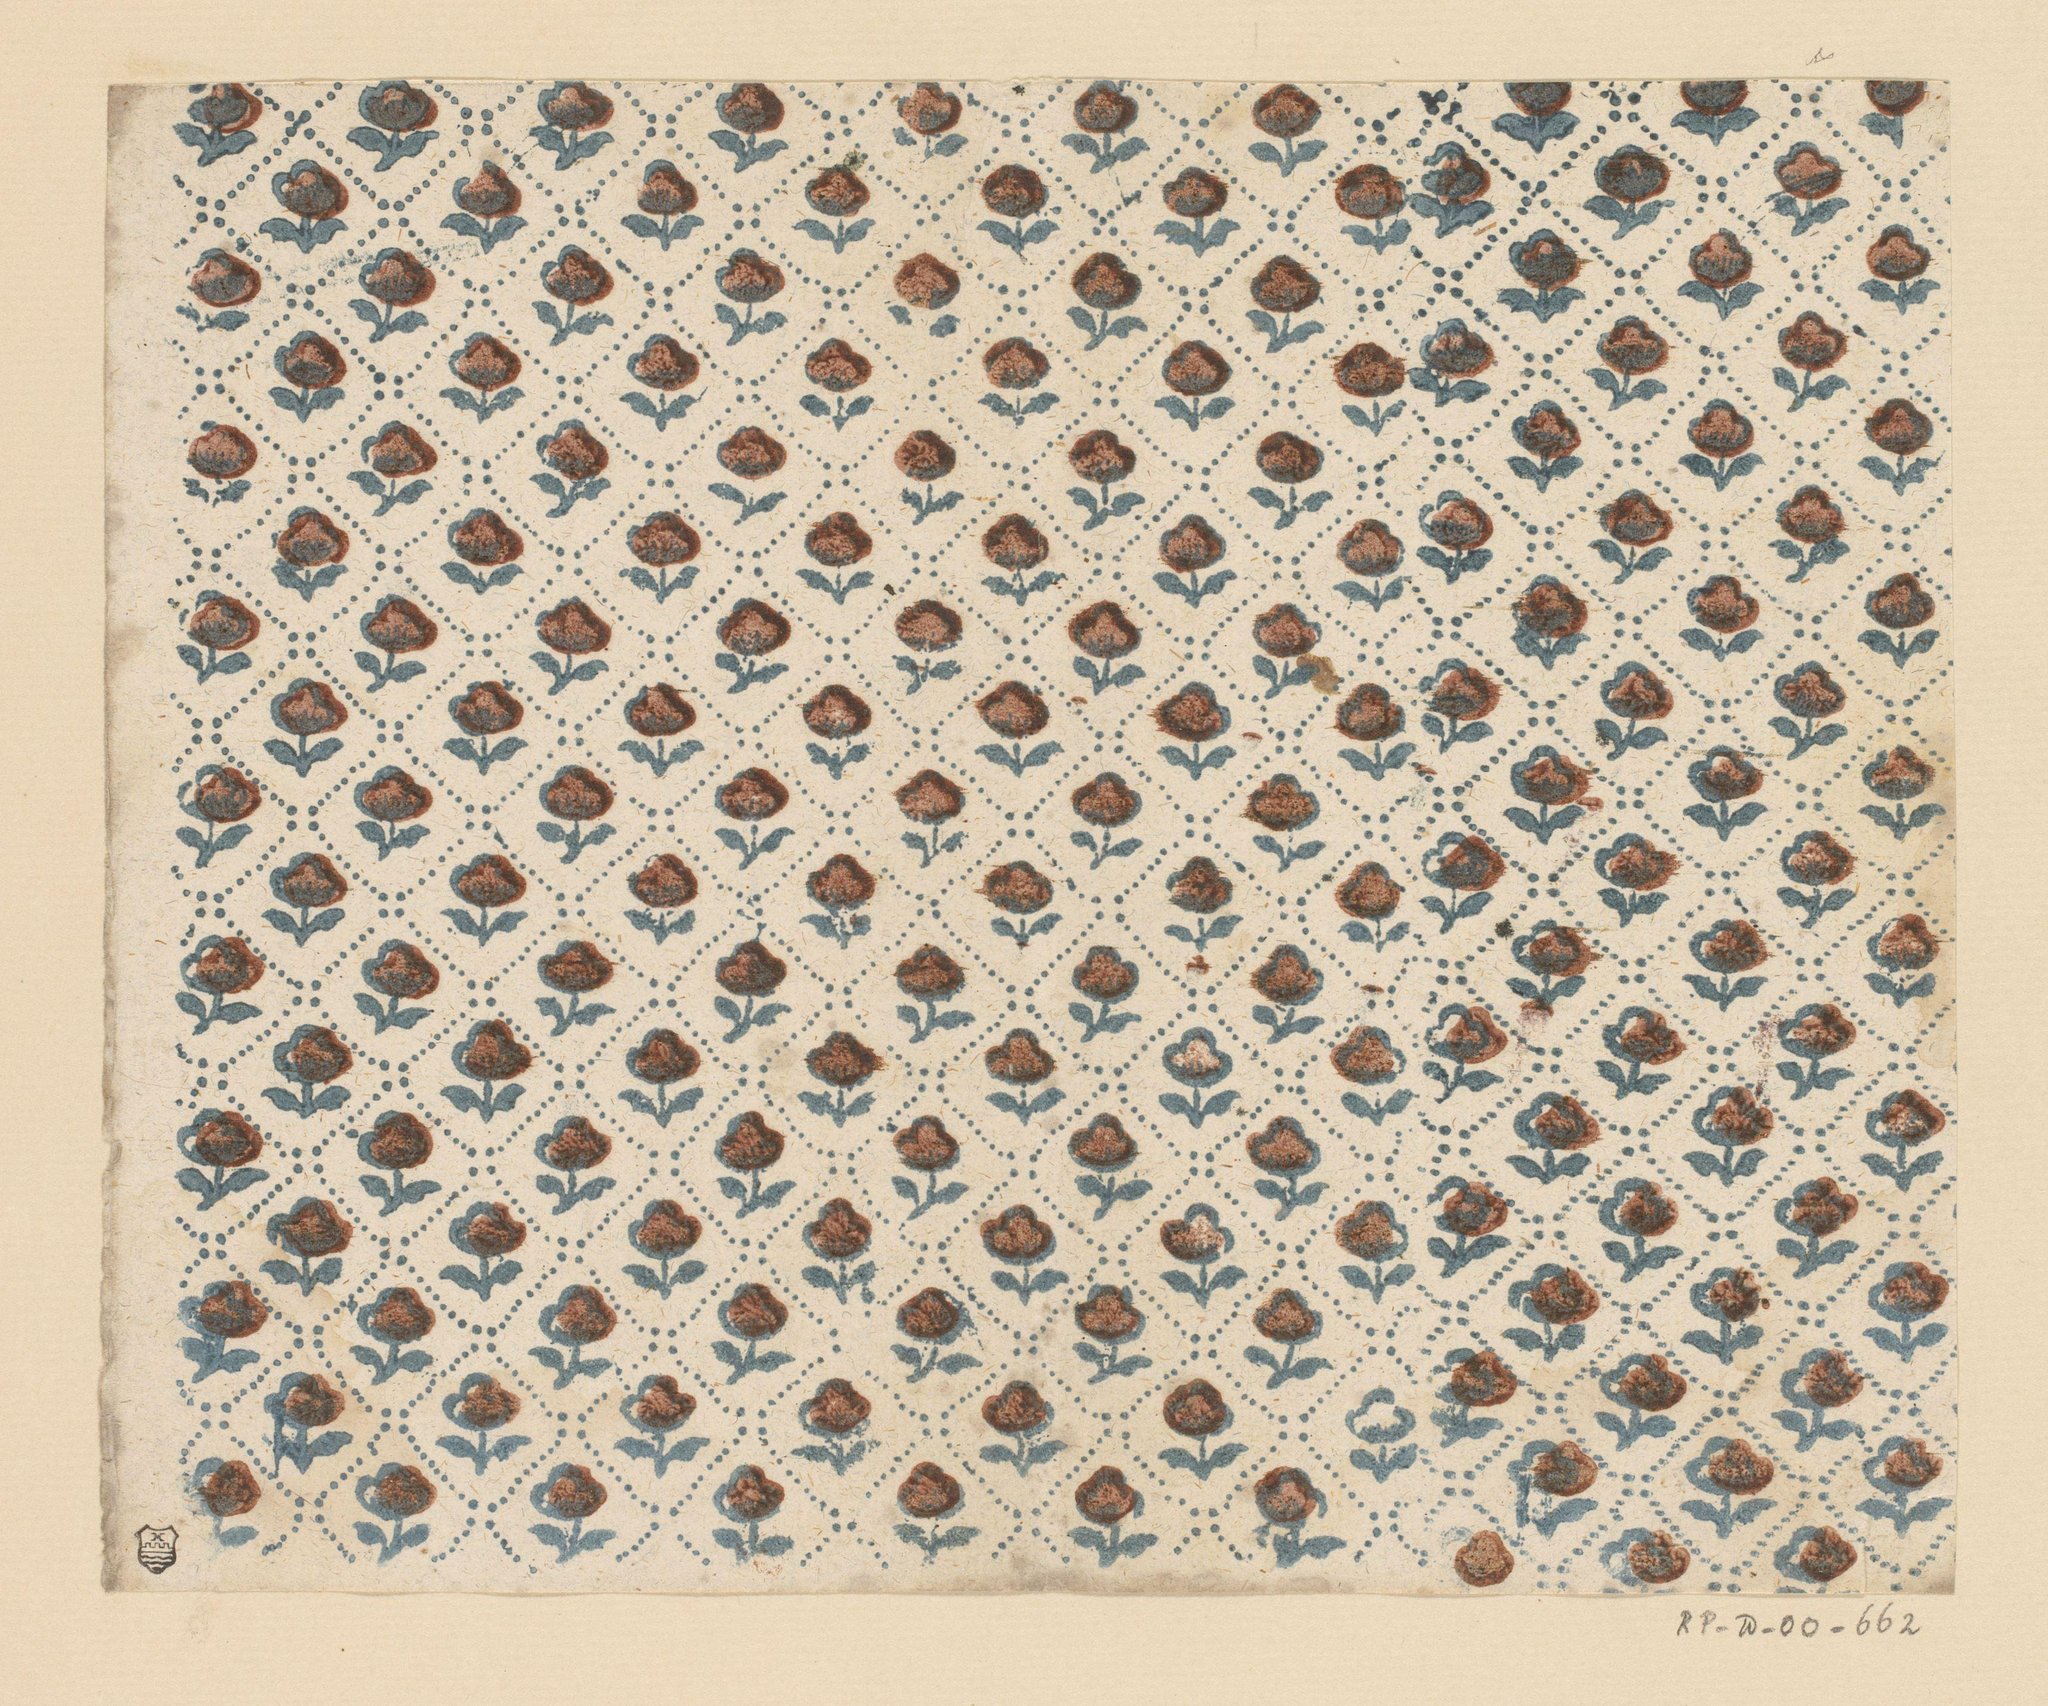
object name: printed paper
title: Blad met ruitenpatroon met bloem als veldvulling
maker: Anonymous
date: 1750-1900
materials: paper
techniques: printing block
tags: ornament derived from plant forms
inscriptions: collector's mark: Lugt 2760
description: Blad met ruitenpatroon met bloem als veldvulling.